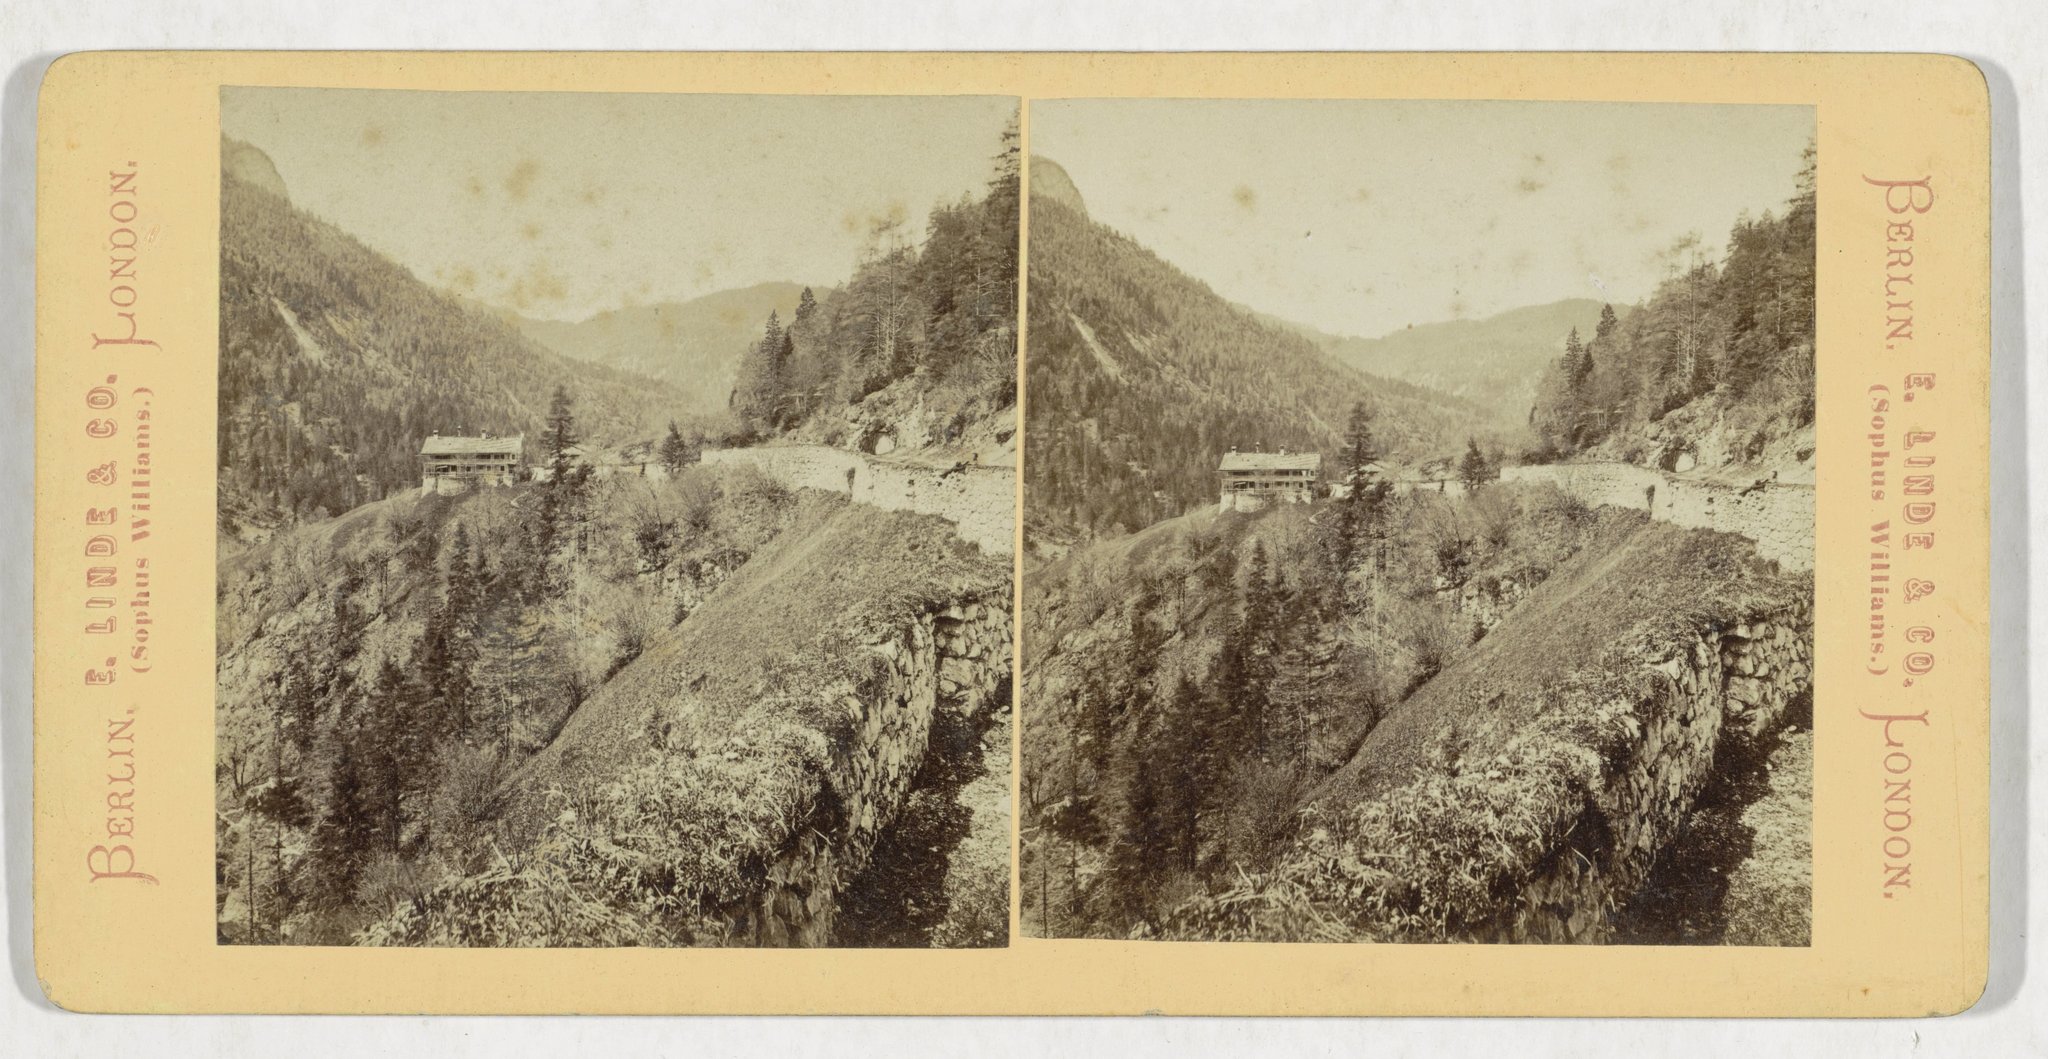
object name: stereograph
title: Hotel Mauthhäusl, nabij Bad Reichenhall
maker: Anonymous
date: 1868-1890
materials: cardboard, paper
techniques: albumen print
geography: bad reichenhall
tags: hotel, hostelry, inn, mountains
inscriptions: number: ‘No 3.’